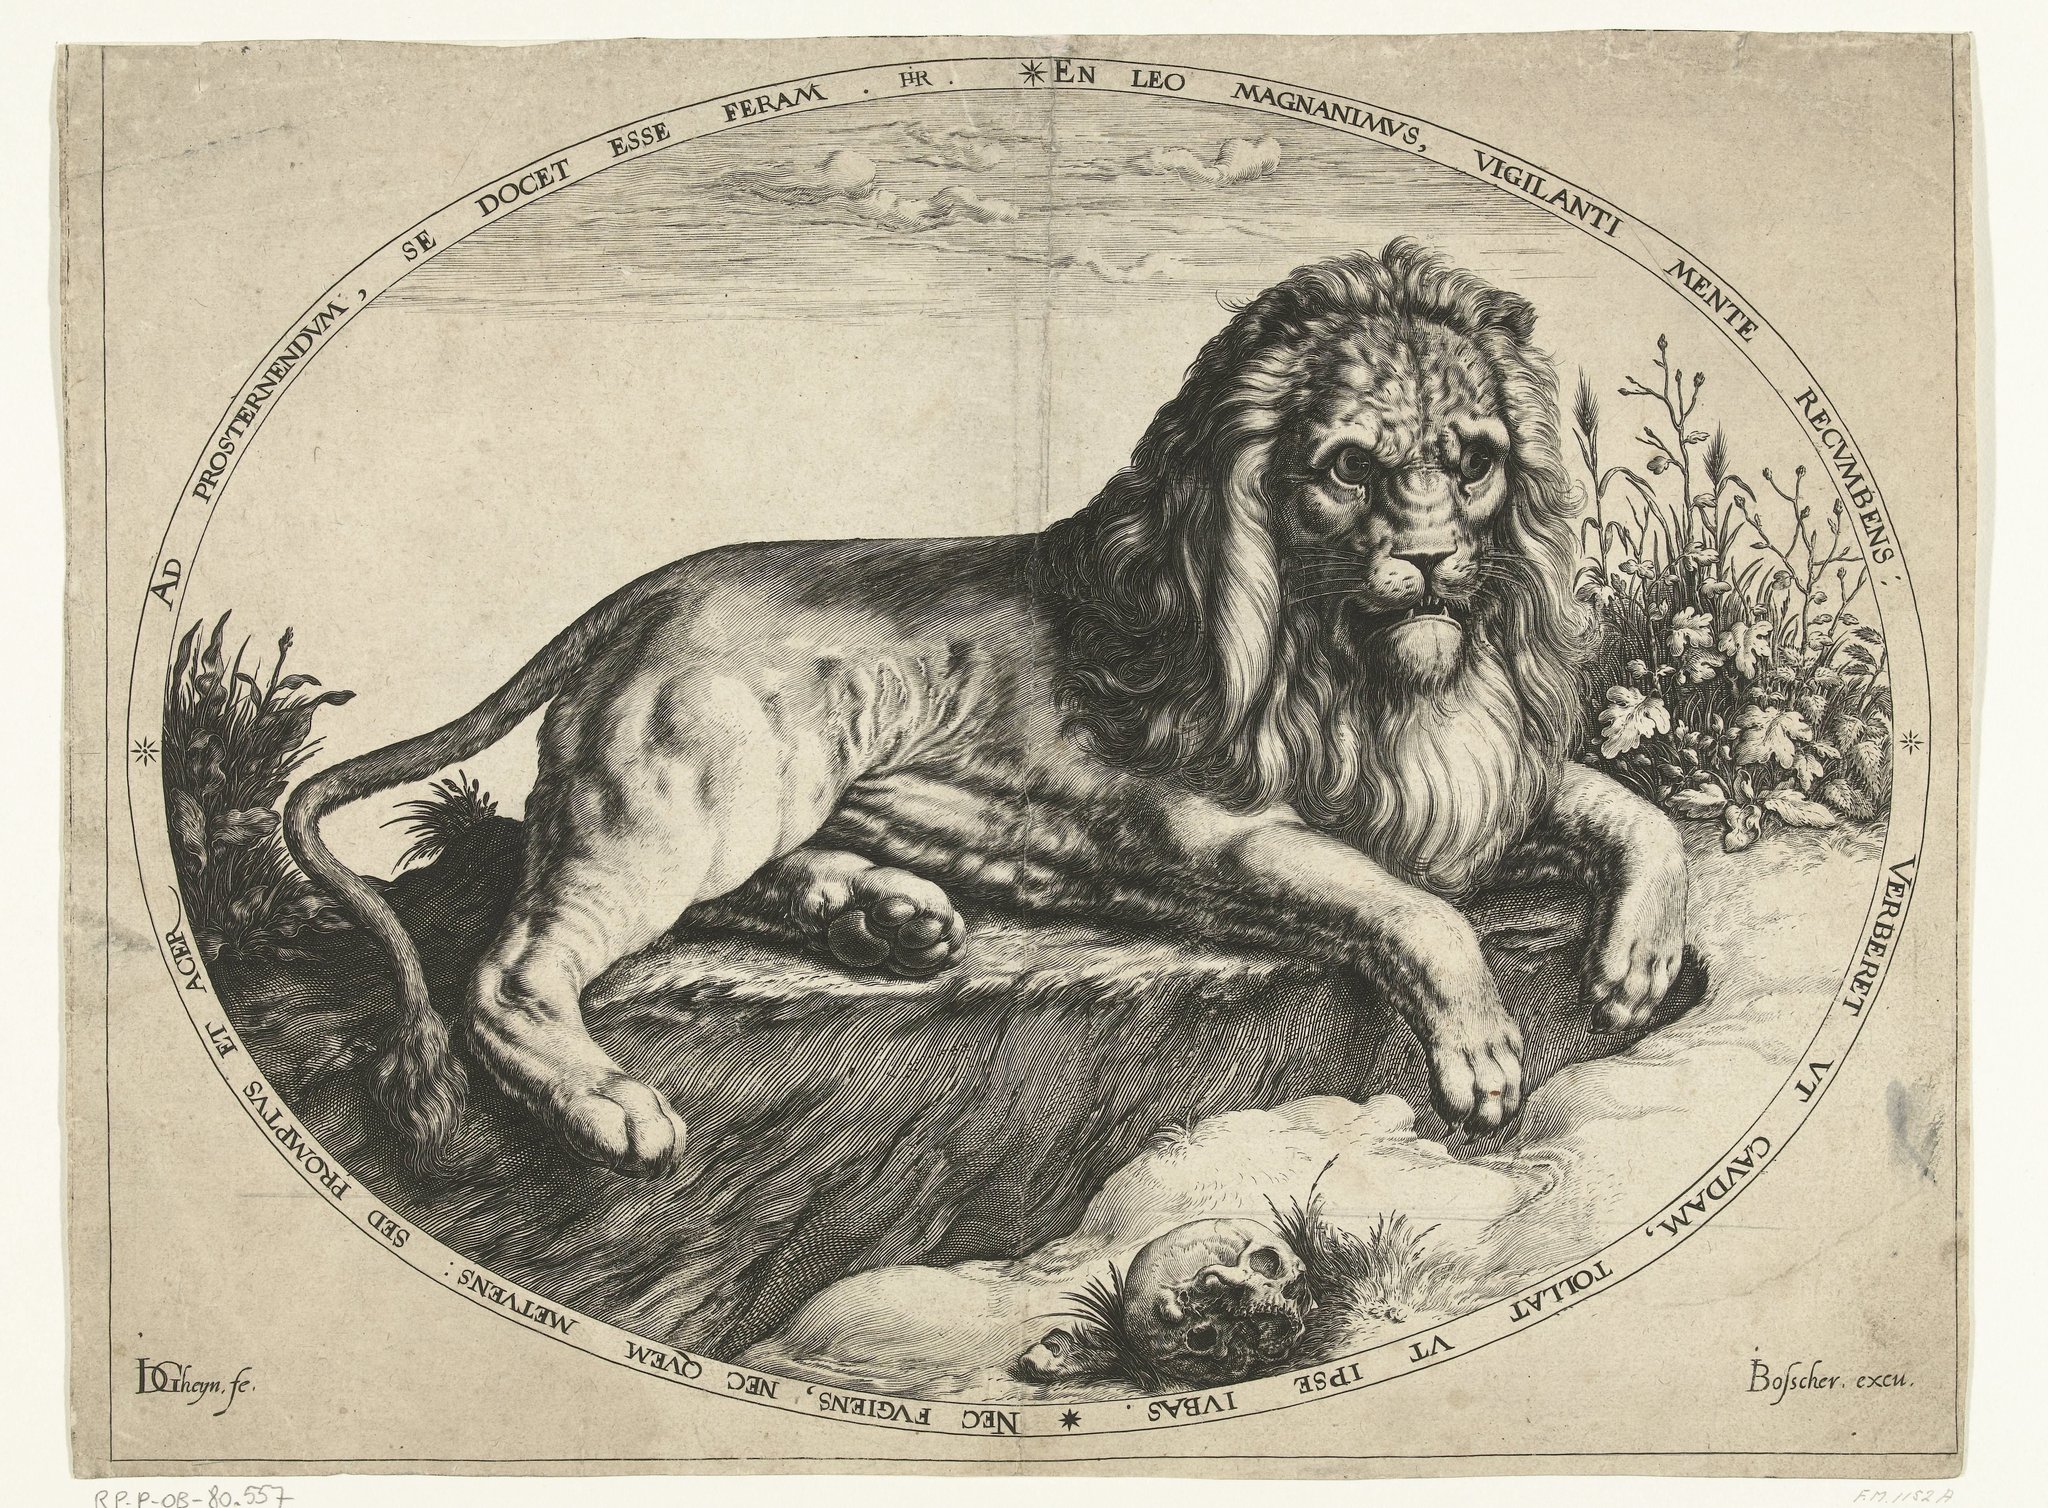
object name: print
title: De leeuw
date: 1588-1592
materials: paper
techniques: engraving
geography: northern netherlands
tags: (human) skull, beasts of prey, predatory animals: lion, battle of nieuwpoort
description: Opgenomen door Muller als (waarschijnlijk) zijnde een zinneprent op de slag bij Nieuwpoort, 1600. De prent dateert echter van daarvoor, ca. 1590.